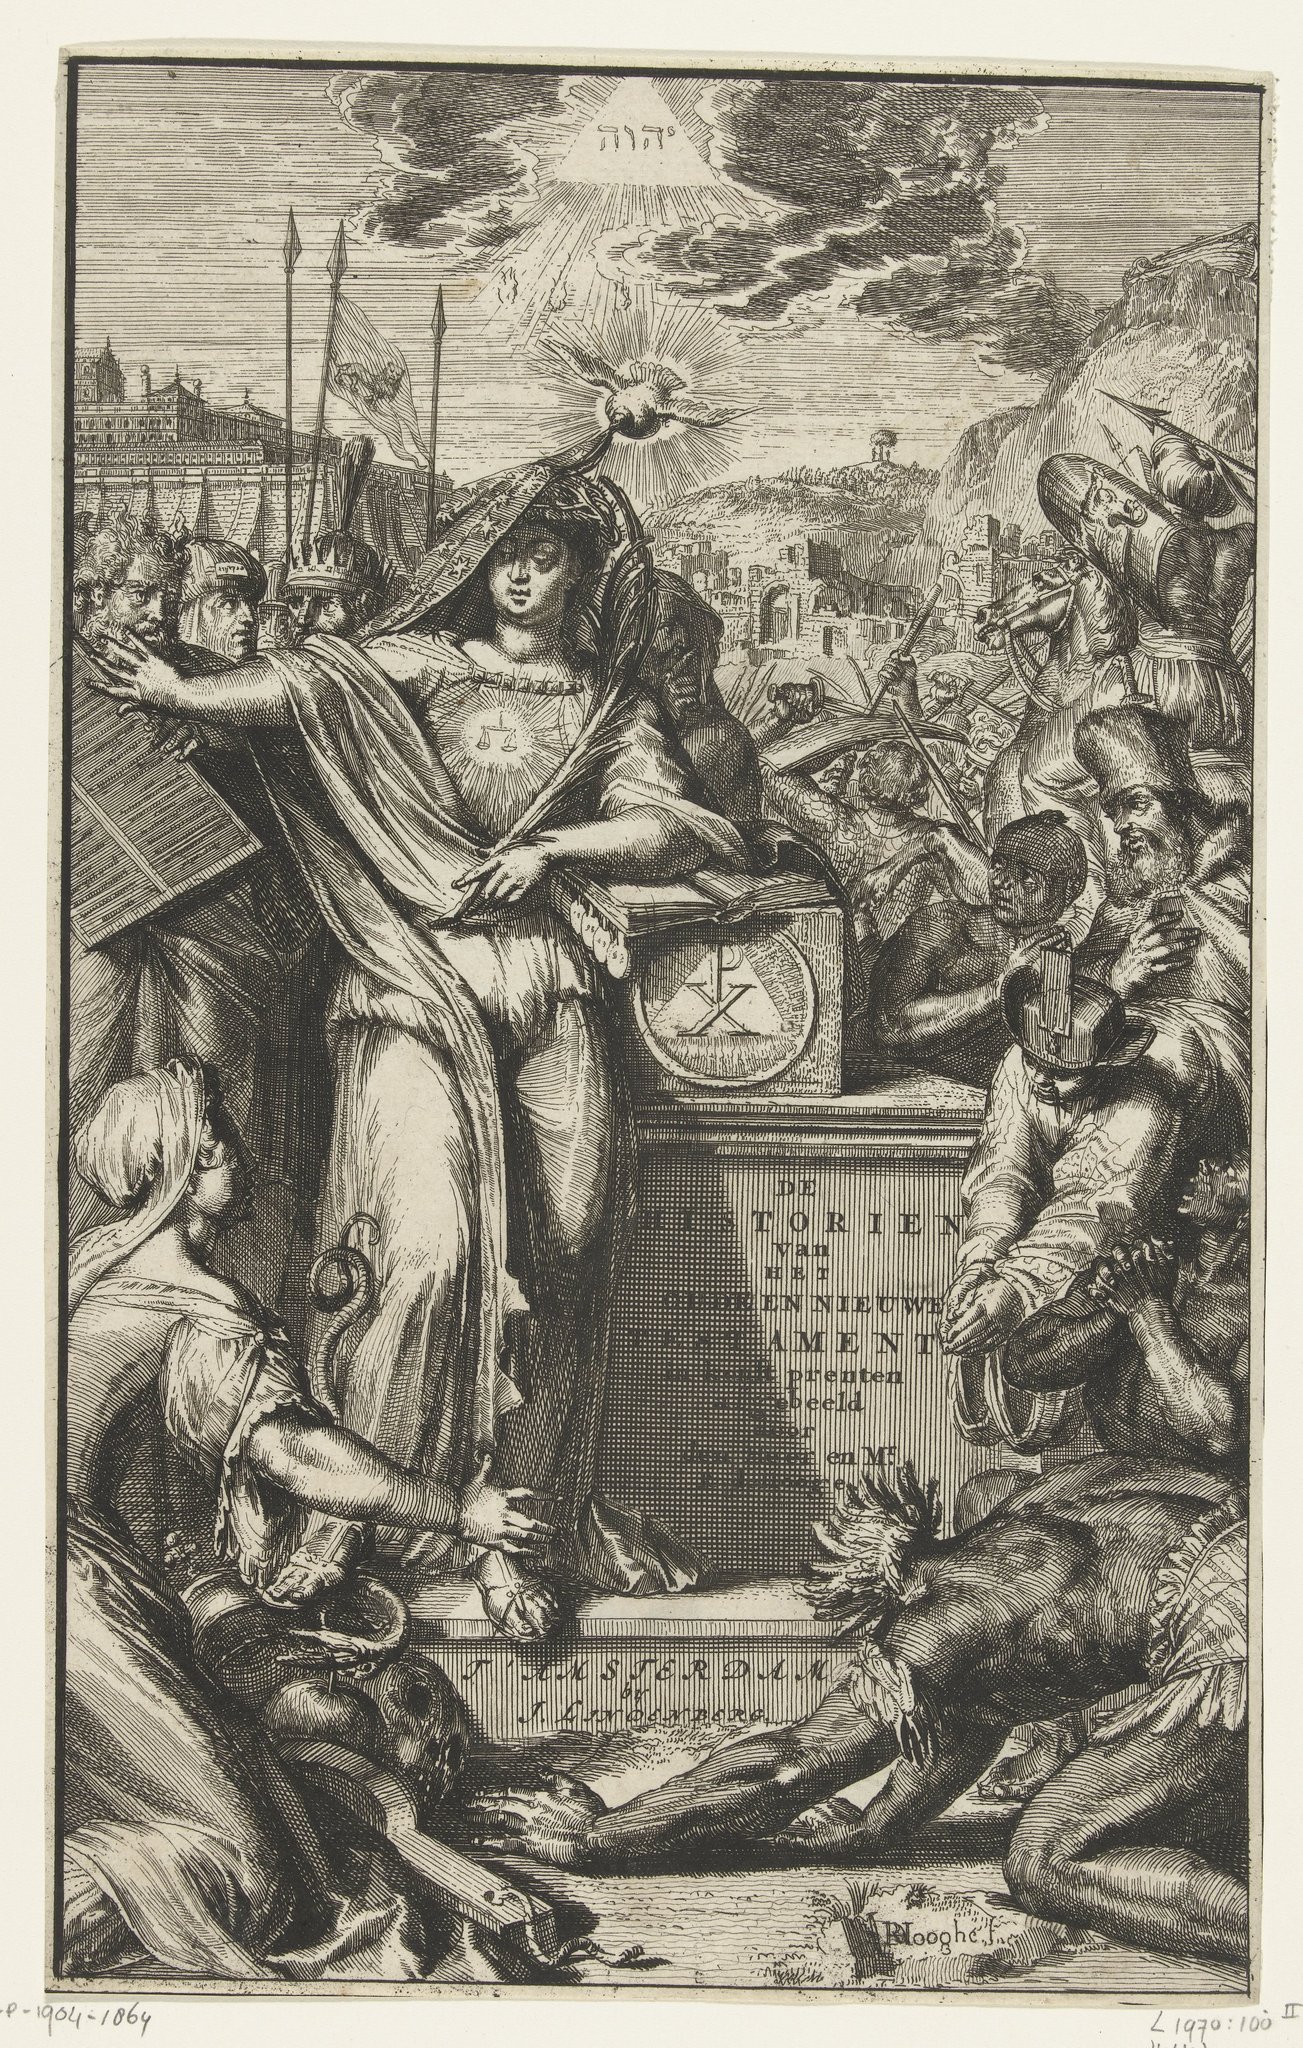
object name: titelprent, frontispice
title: Titelprent voor: Henricus Vos, Alle de voornaamste historien des Ouden en Nieuwen Testaments. Verbeeld in uytsteekende konst-platen, 2 delen, Amsterdam, 1703.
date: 1703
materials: paper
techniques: engraving, etching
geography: netherlands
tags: christian religion (+ holy ghost (as a dove)), tetragram (in roman or hebrew script) ~ symbol of god the father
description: Titelprent voor: Henricus Vos, Alle de voornaamste historien des Ouden en Nieuwen Testaments. Verbeeld in uytsteekende konst-platen, 2 delen, Amsterdam, 1703.